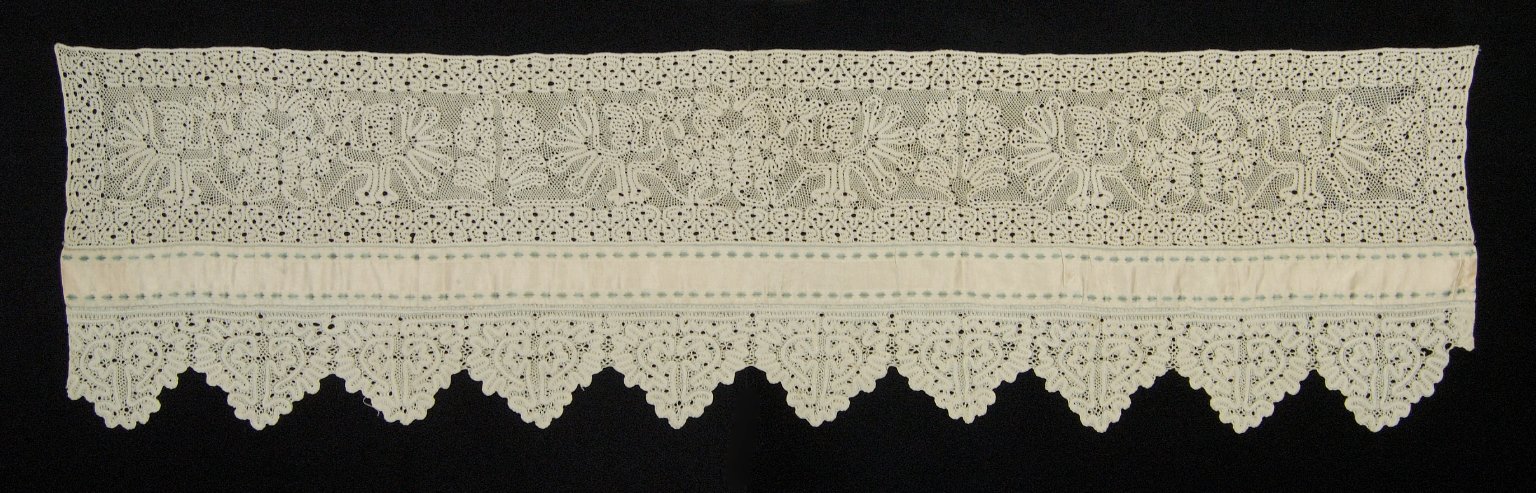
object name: border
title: Bed curtain border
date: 1790-1825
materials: linen, silk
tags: birds